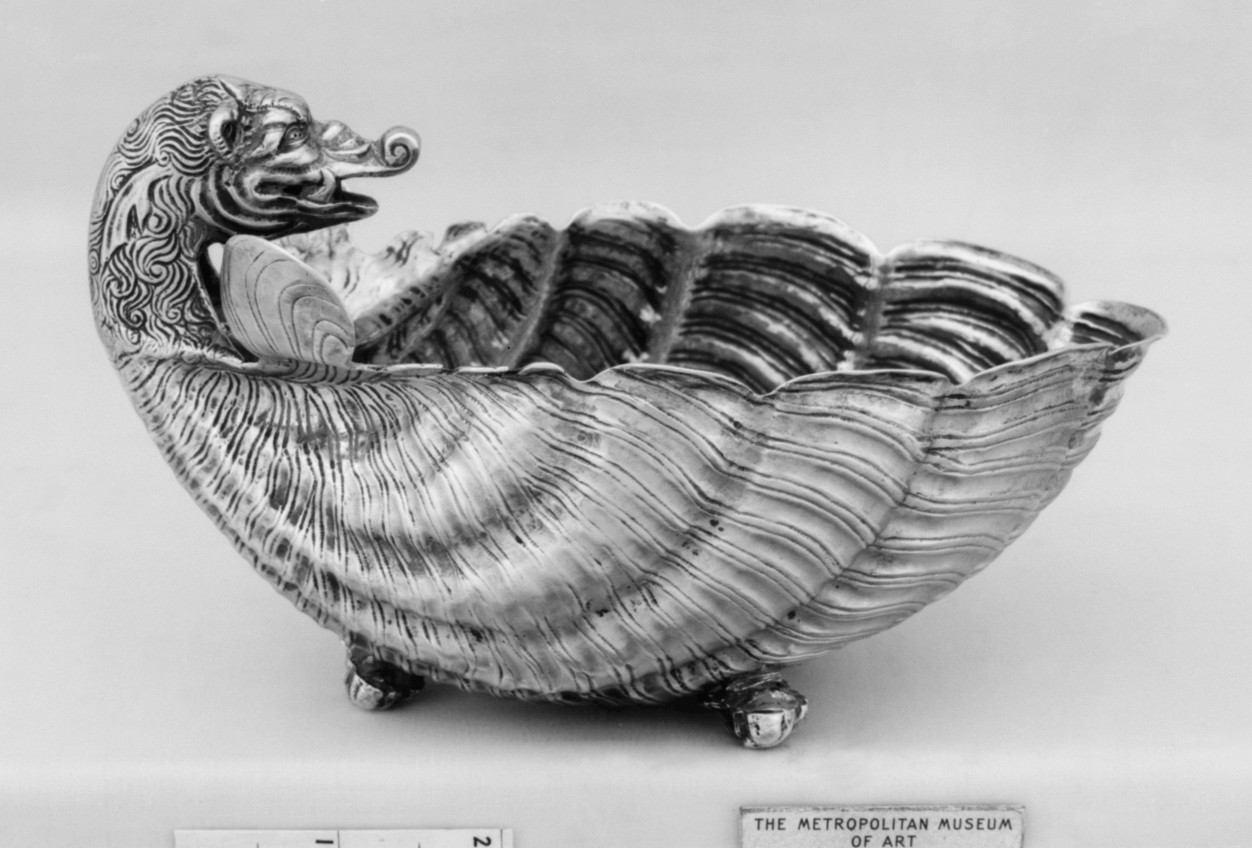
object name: dish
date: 1701-1800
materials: silver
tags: shells